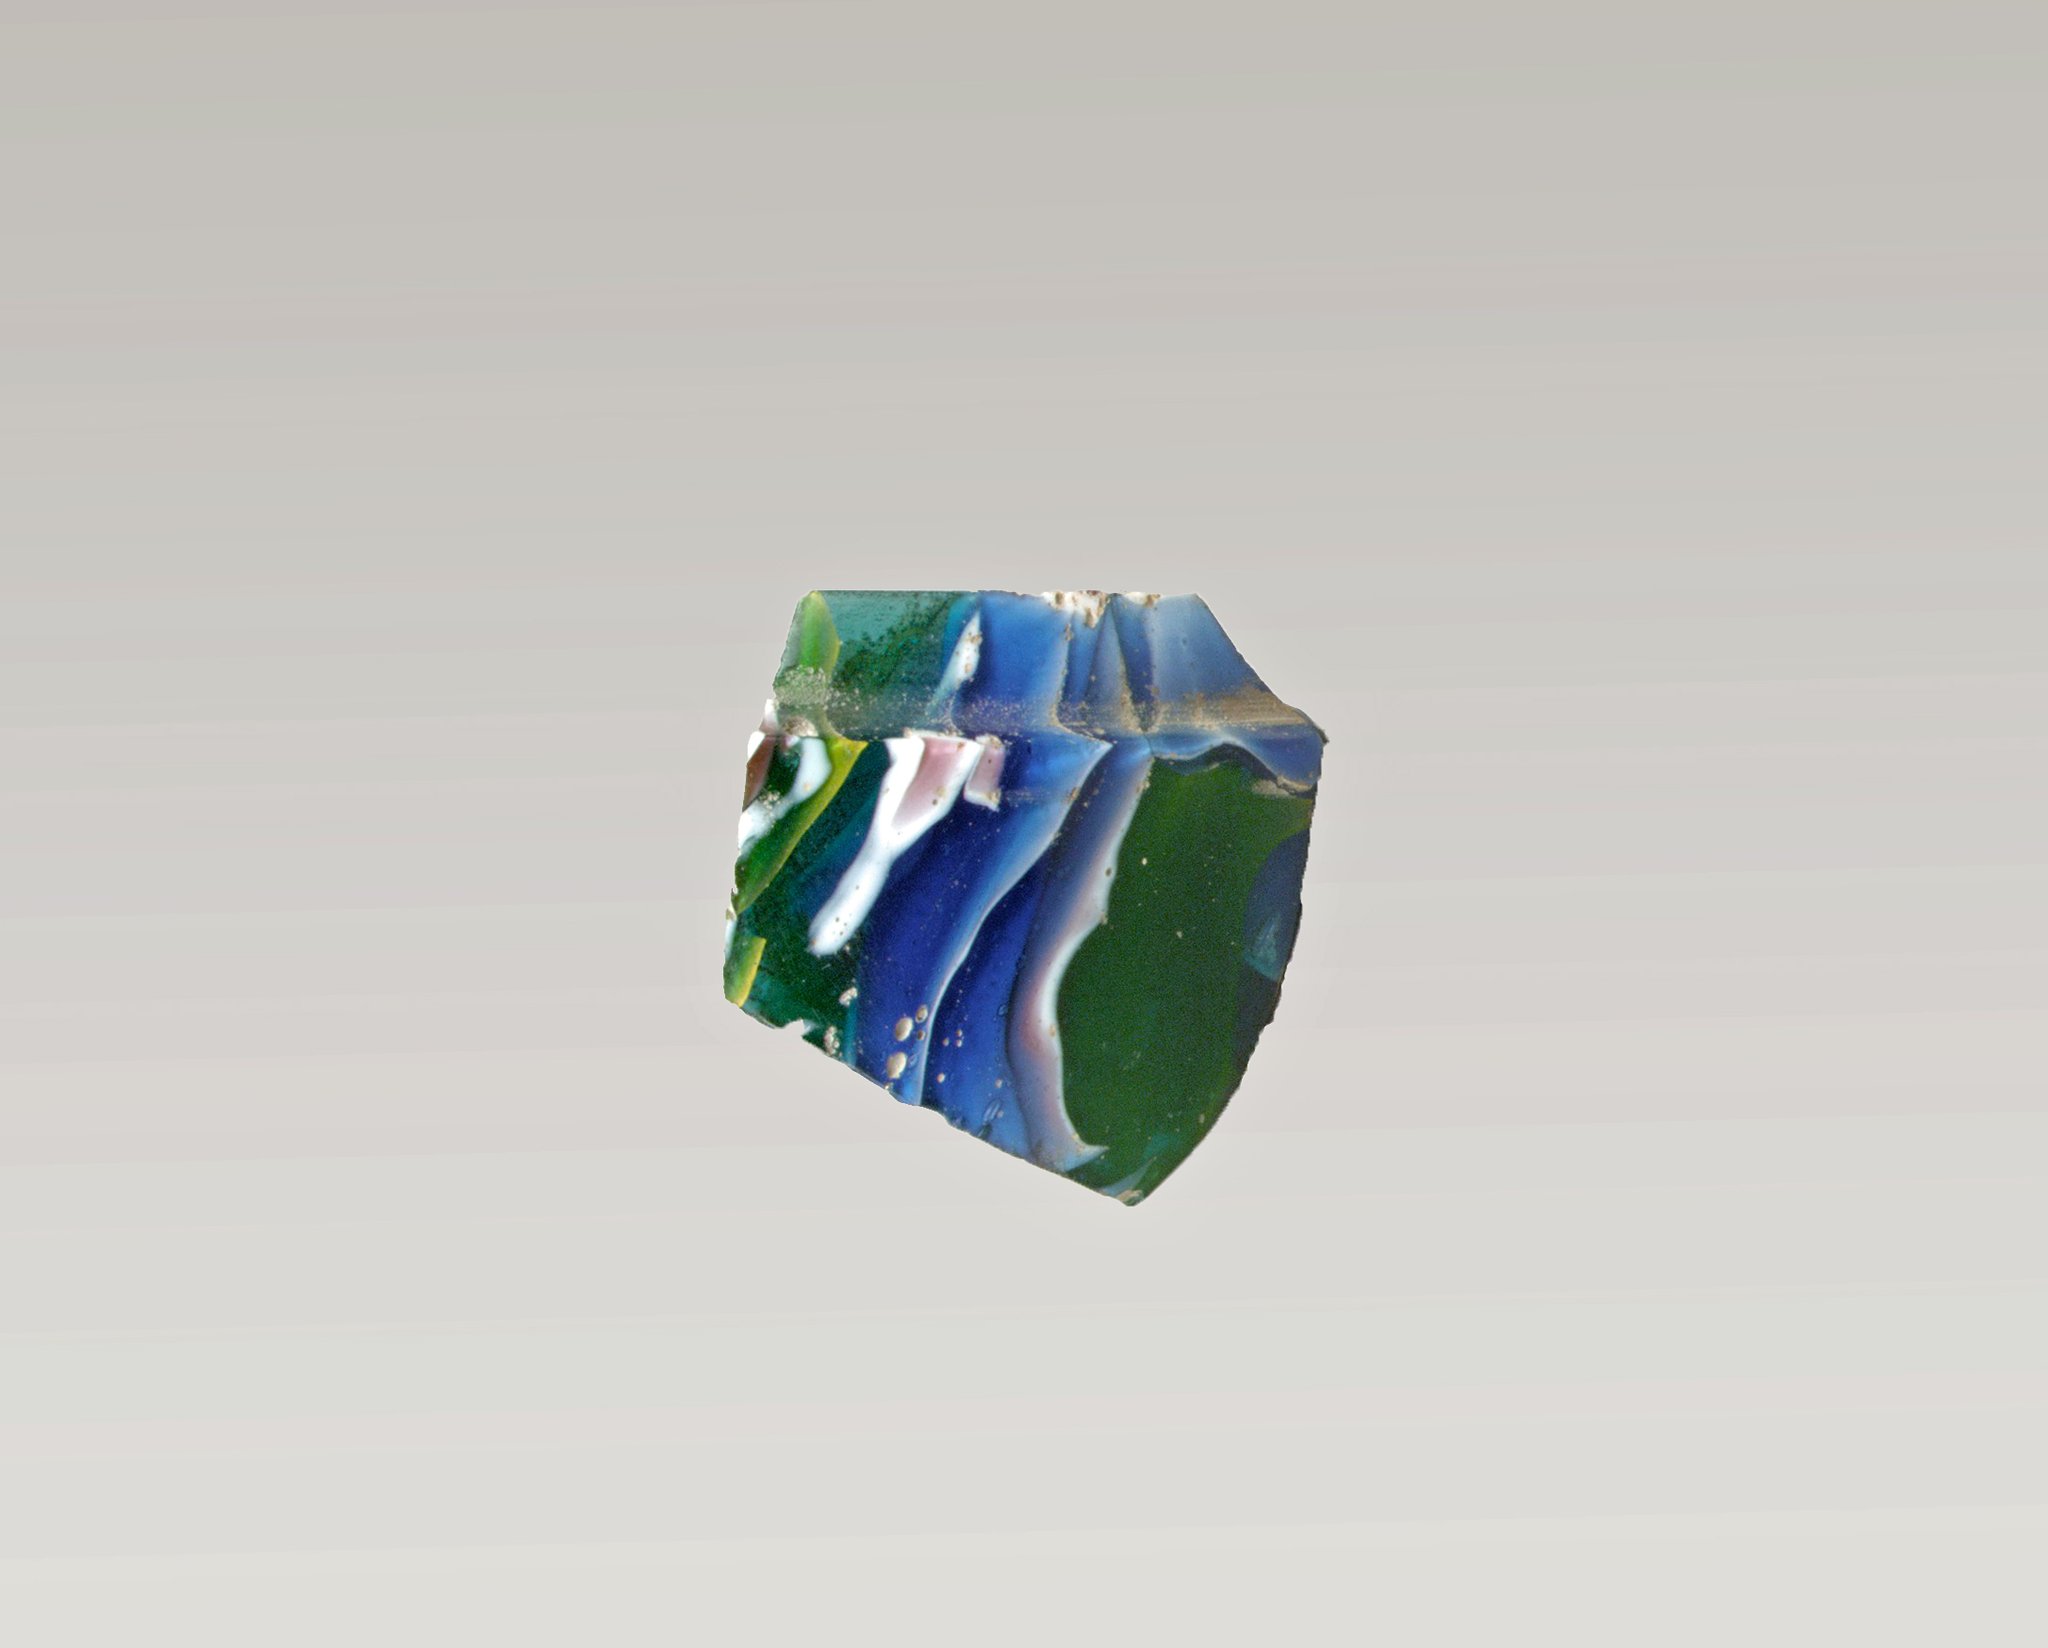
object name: fragment, mosaic box pyxis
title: Glass mosaic box (pyxis) fragment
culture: roman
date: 34 BCE-33 CE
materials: glass